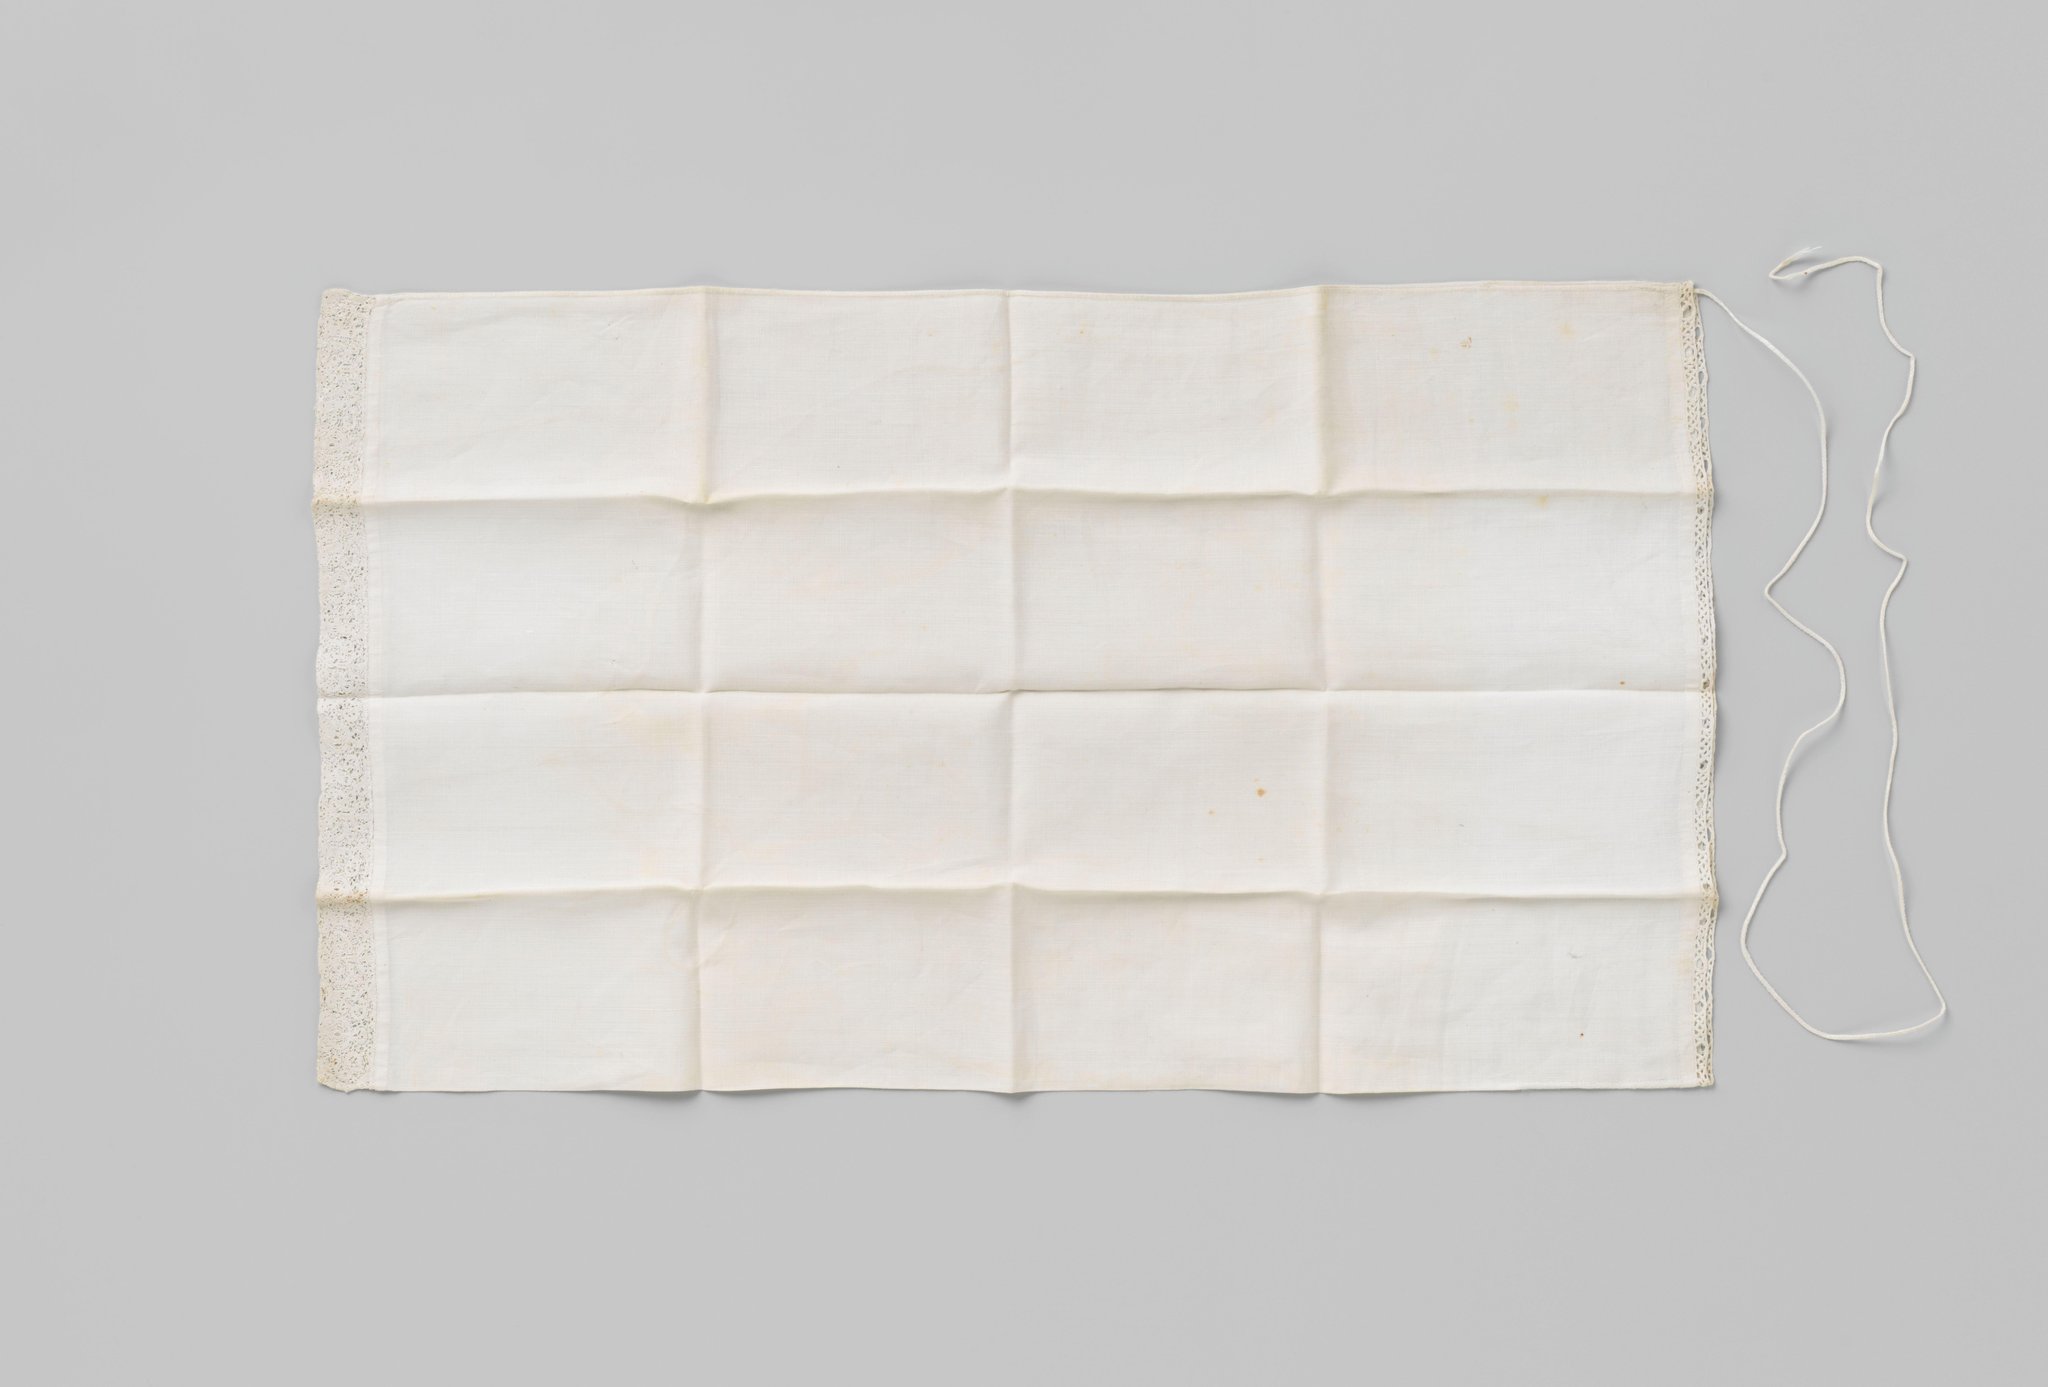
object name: lendensloop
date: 1650-1660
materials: linen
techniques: lace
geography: northern netherlands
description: Lendensloop van linnen met een entre-deux van kloskant, merk 5? Aan het sluiteinde een geklost randje.